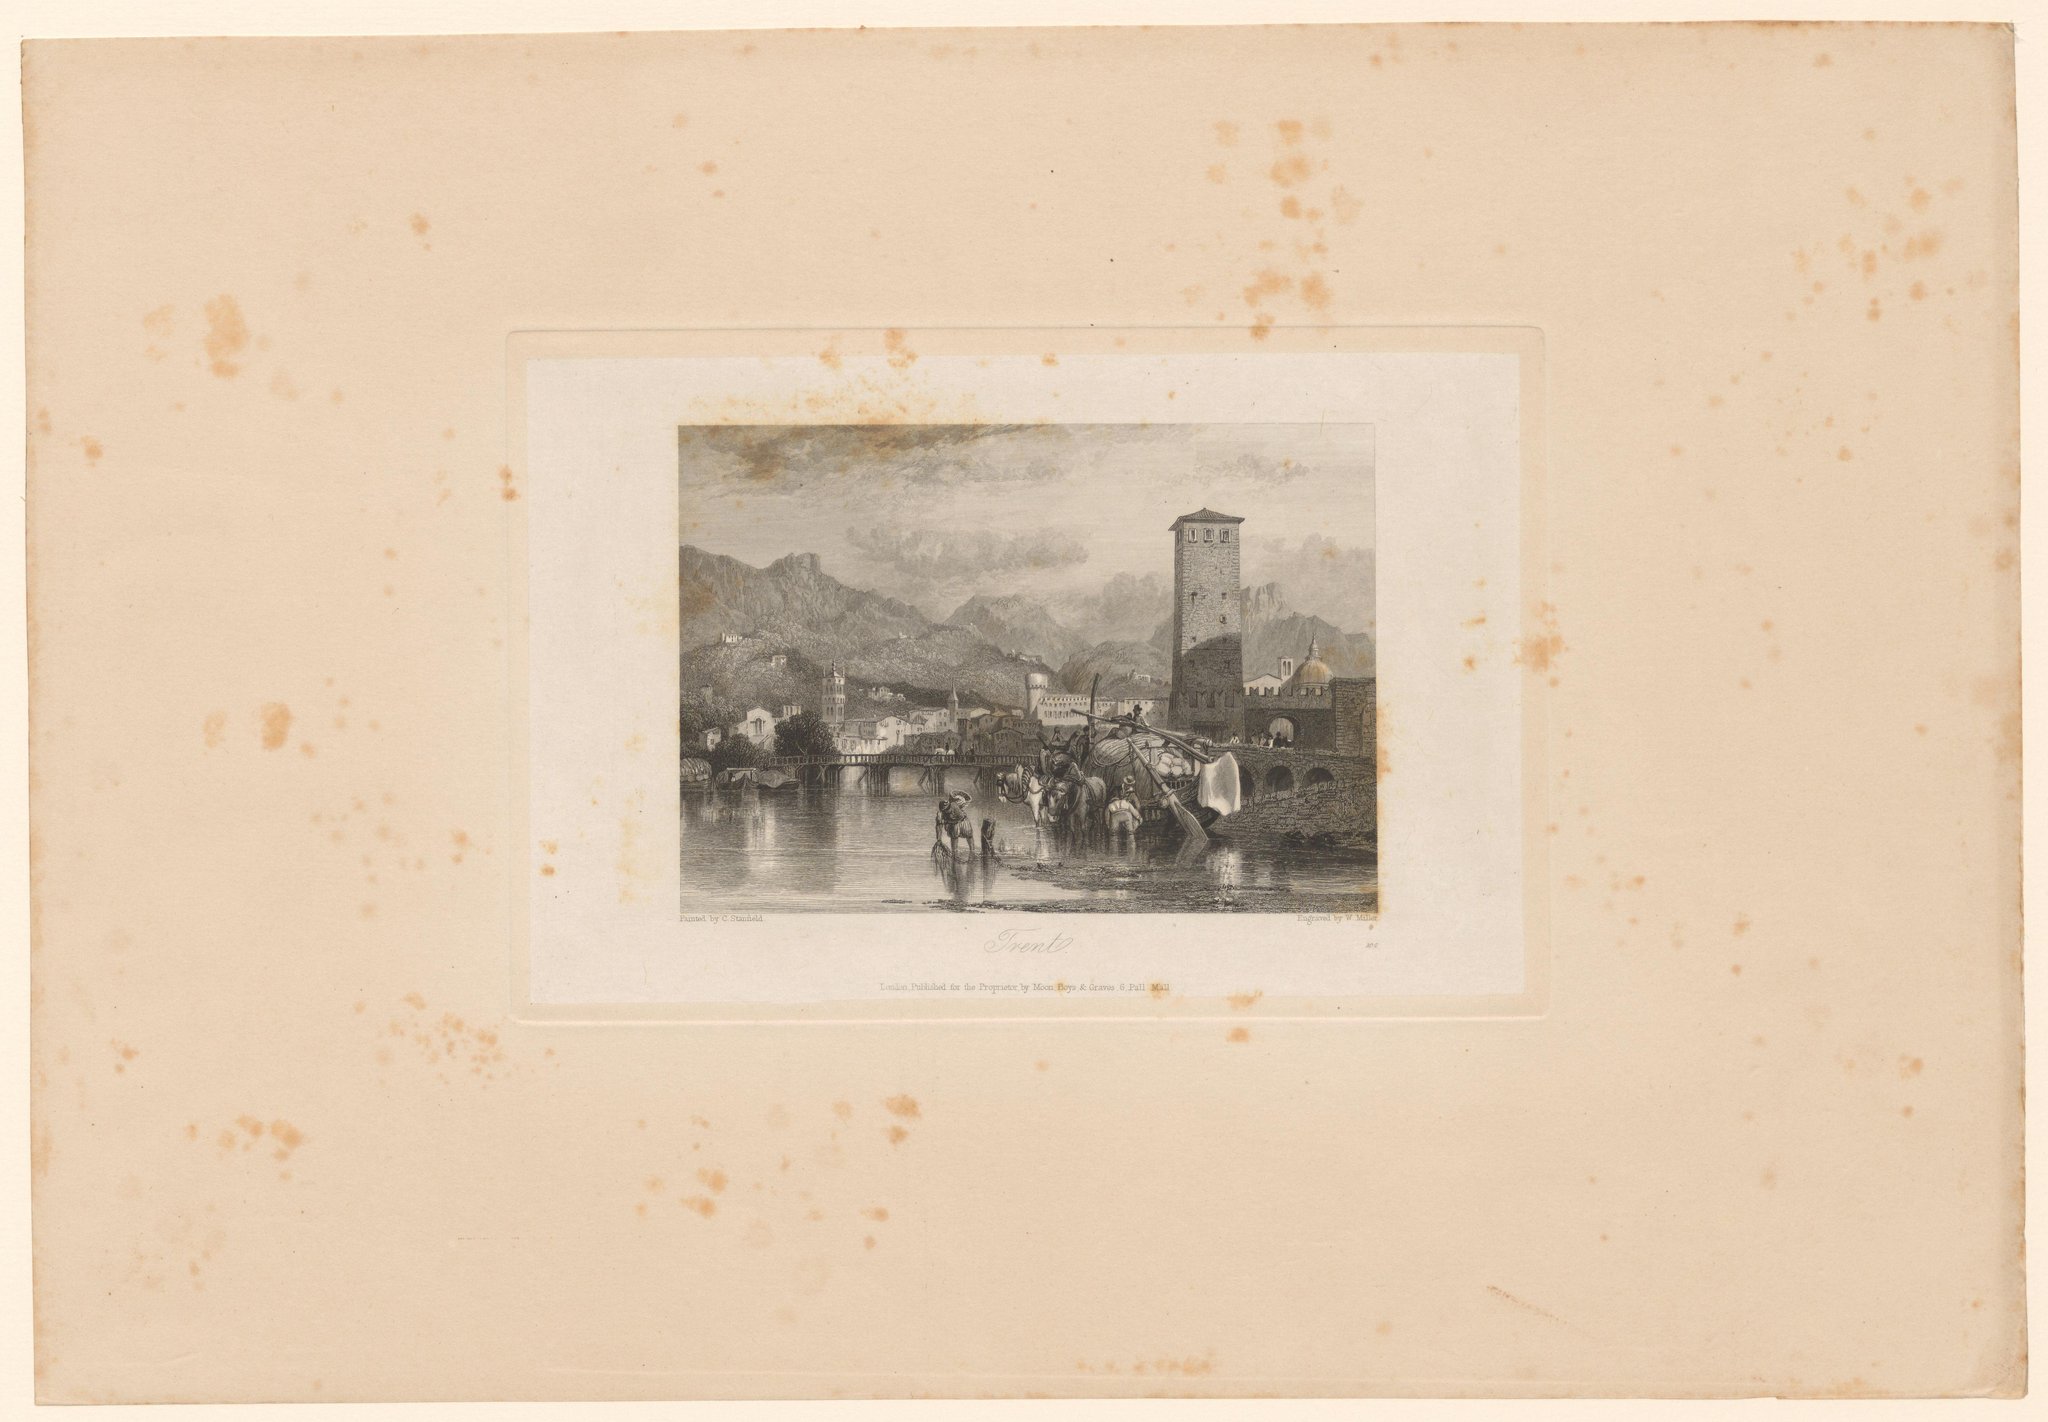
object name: print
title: Gezicht op Trente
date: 1832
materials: paper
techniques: etching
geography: edinburgh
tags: city-view in general; 'veduta', river, mountains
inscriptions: collector's mark: Lugt 2228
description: Andere staat gebruikt in: Heath's Picturesque Annual. Travelling sketches in the north of Italy, the Tyrol and on the Rhine (...). Londen: Longman et al., 1832.